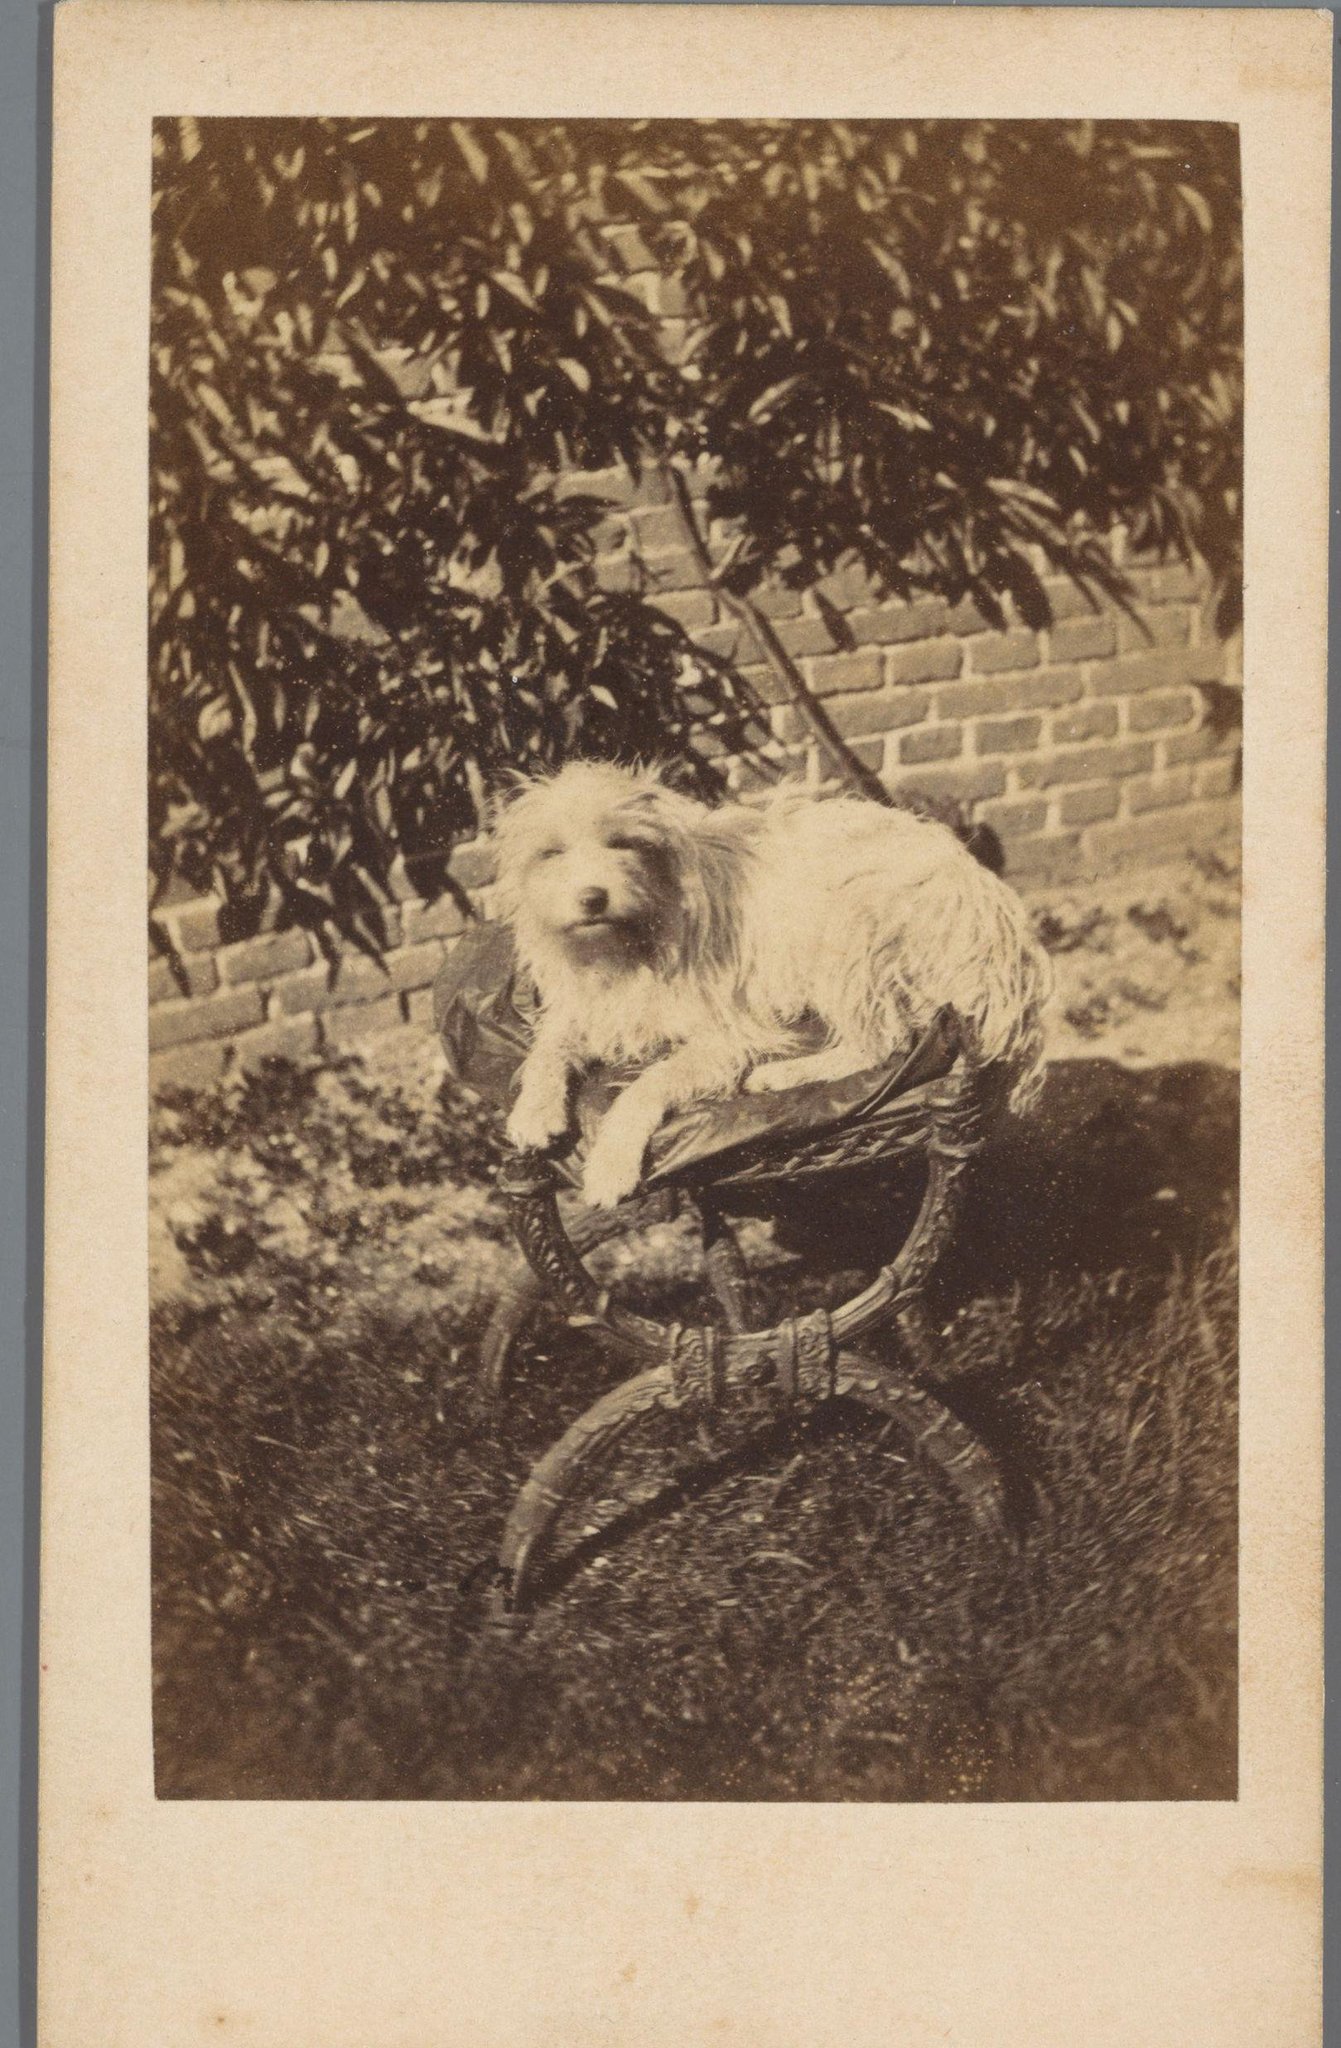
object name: carte de visite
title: Portret van een hond op een stoel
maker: Anonymous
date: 1854-1885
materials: cardboard, paper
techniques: albumen print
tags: anonymous historical person portrayed, dog